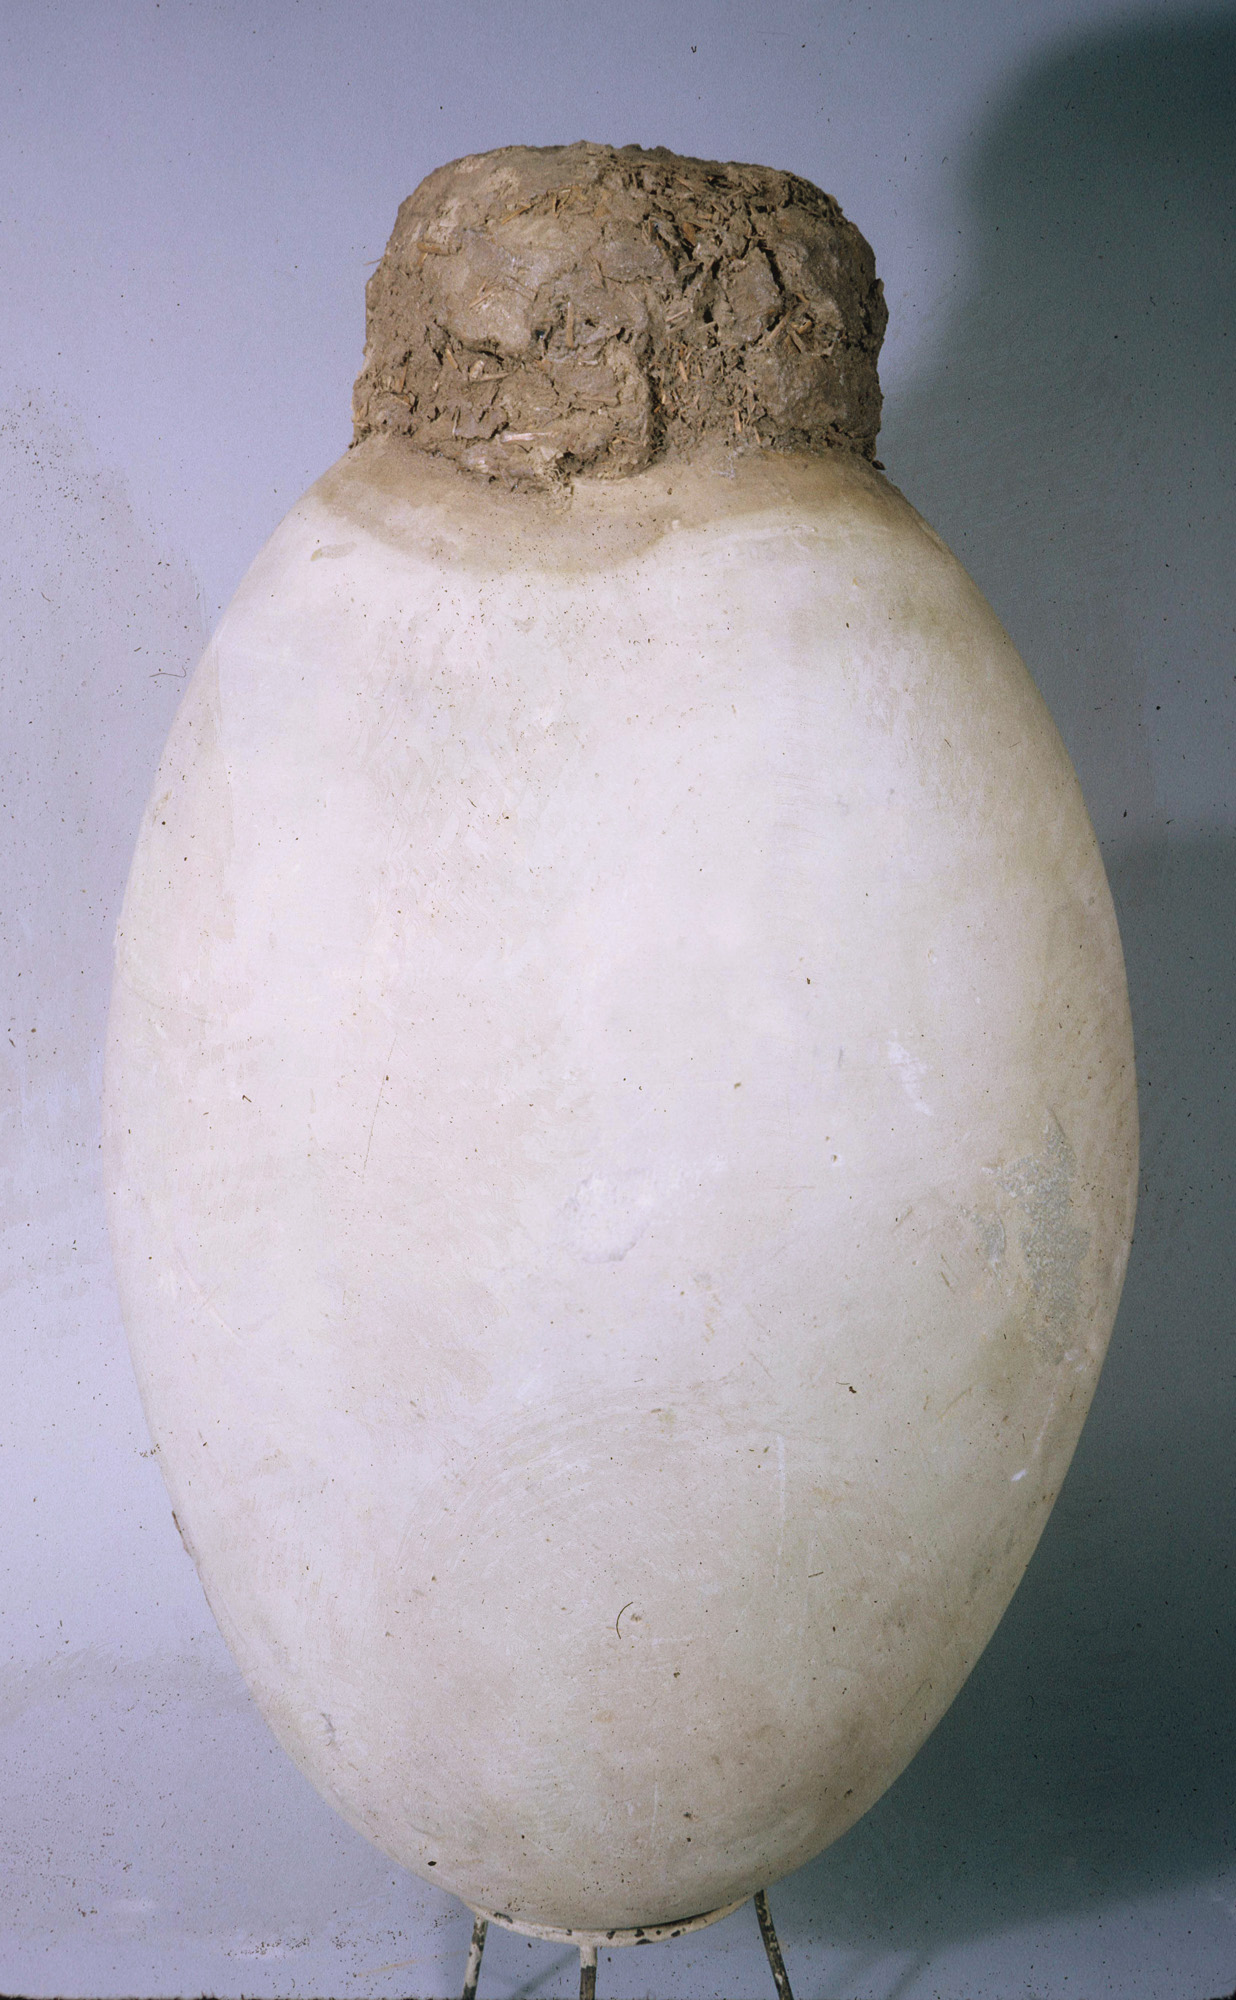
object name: jar mummifing material, ipy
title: Jar containing mummifying materials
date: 2030-1640 BCE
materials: clay, pottery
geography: egypt